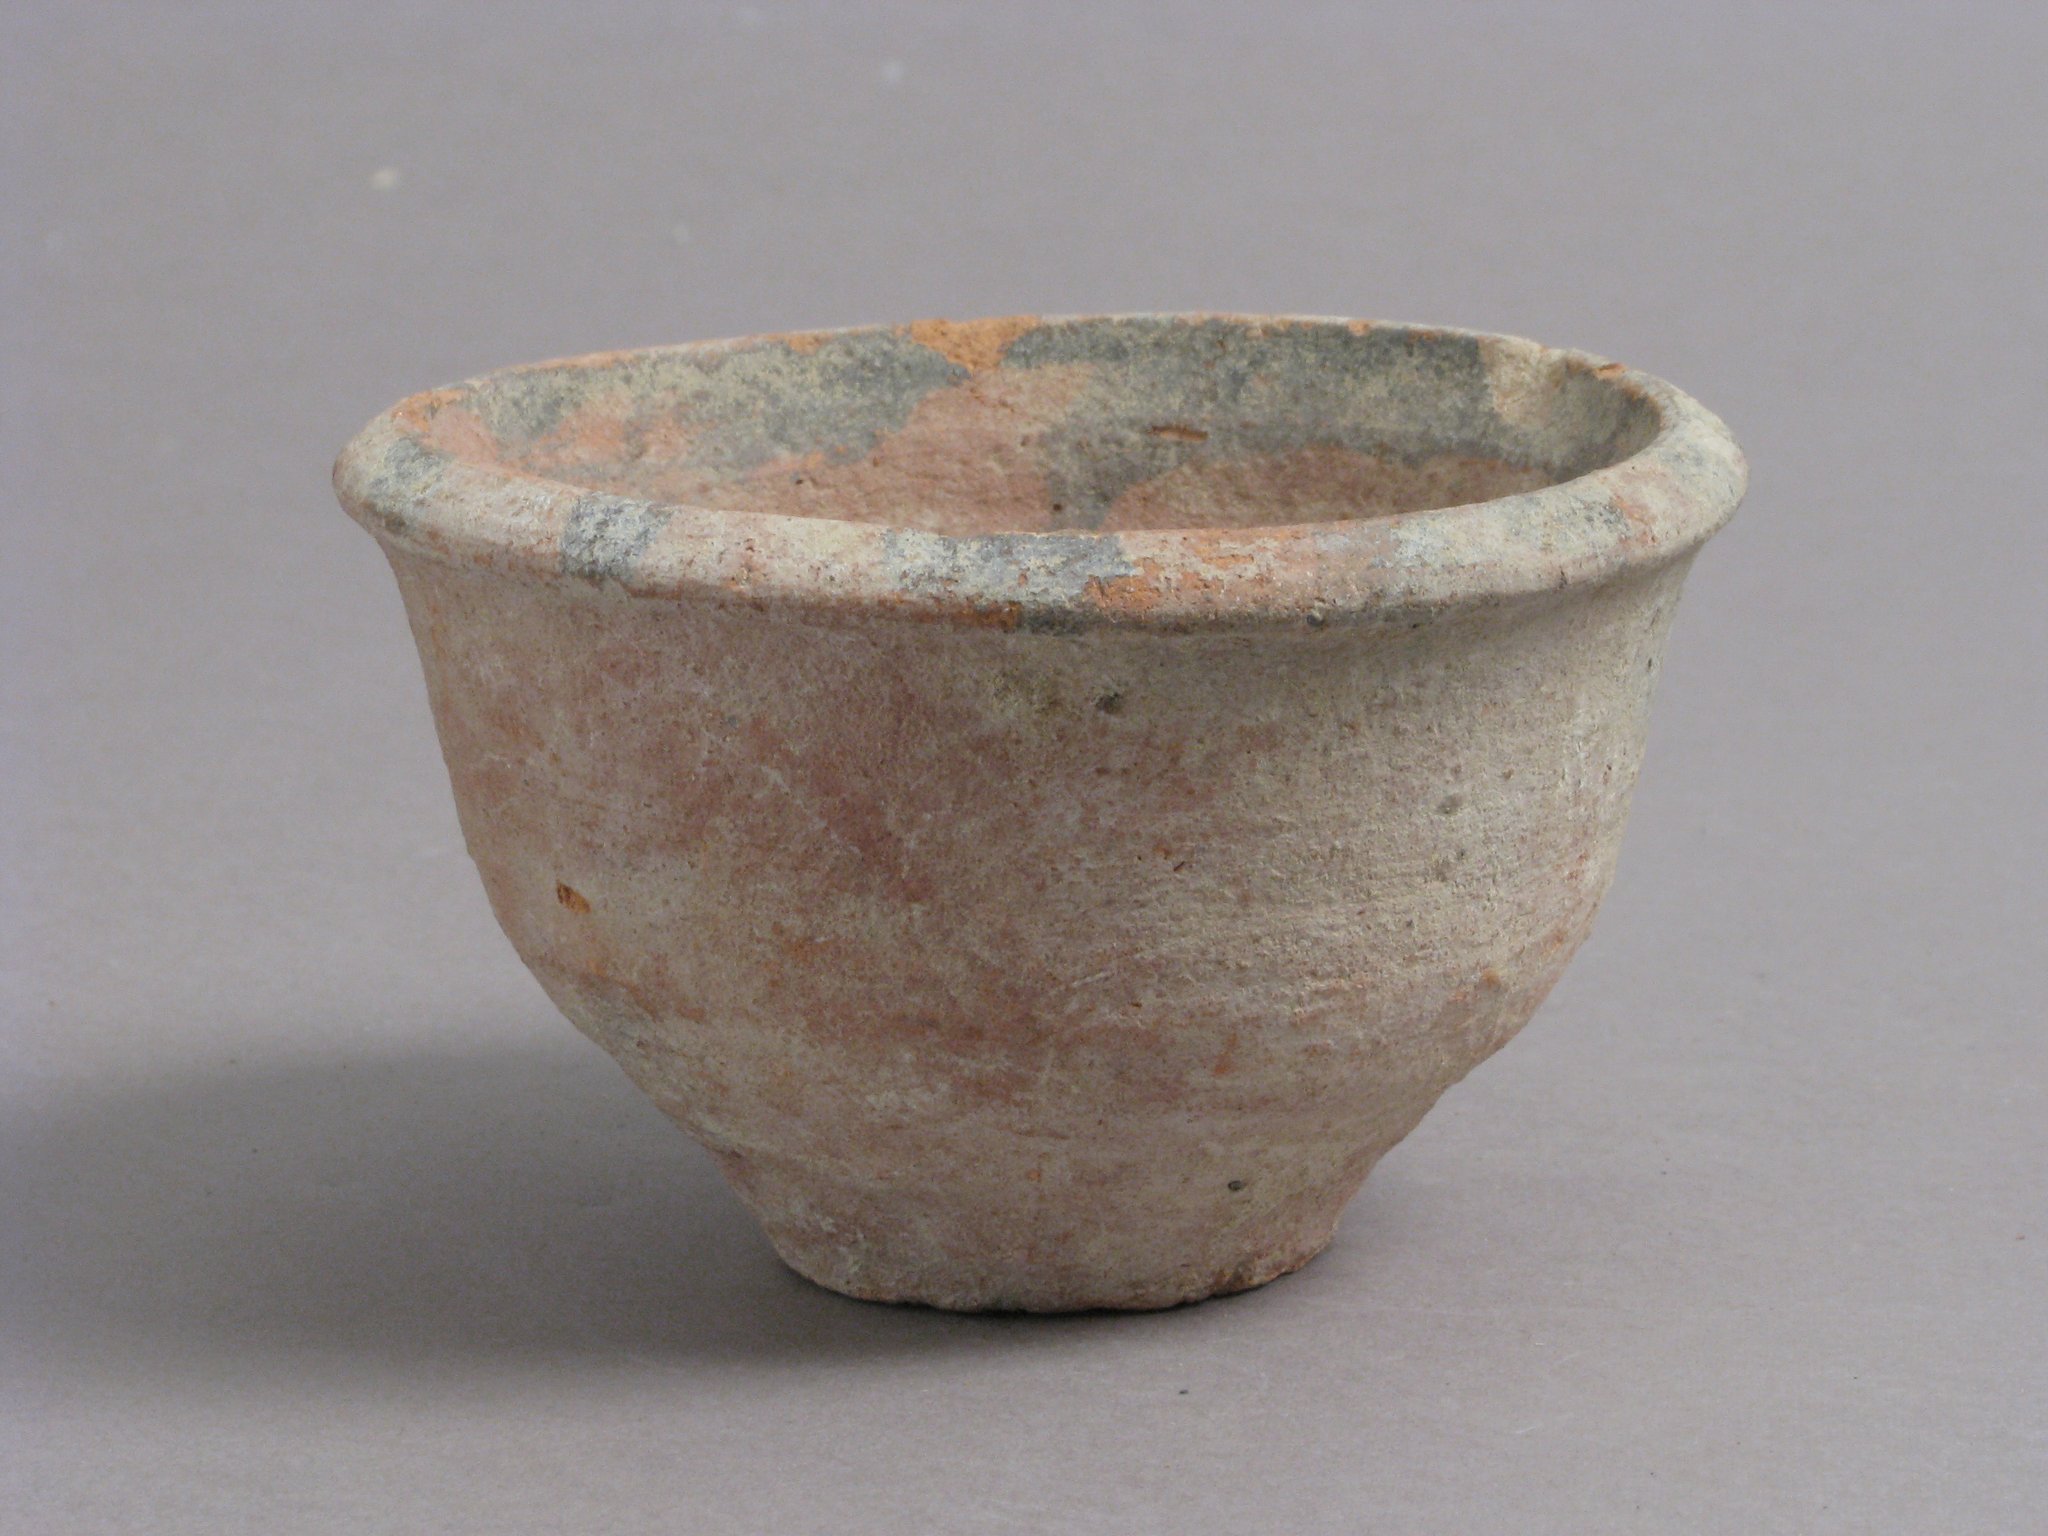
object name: bowl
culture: coptic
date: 301-700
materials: earthenware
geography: egypt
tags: bowls